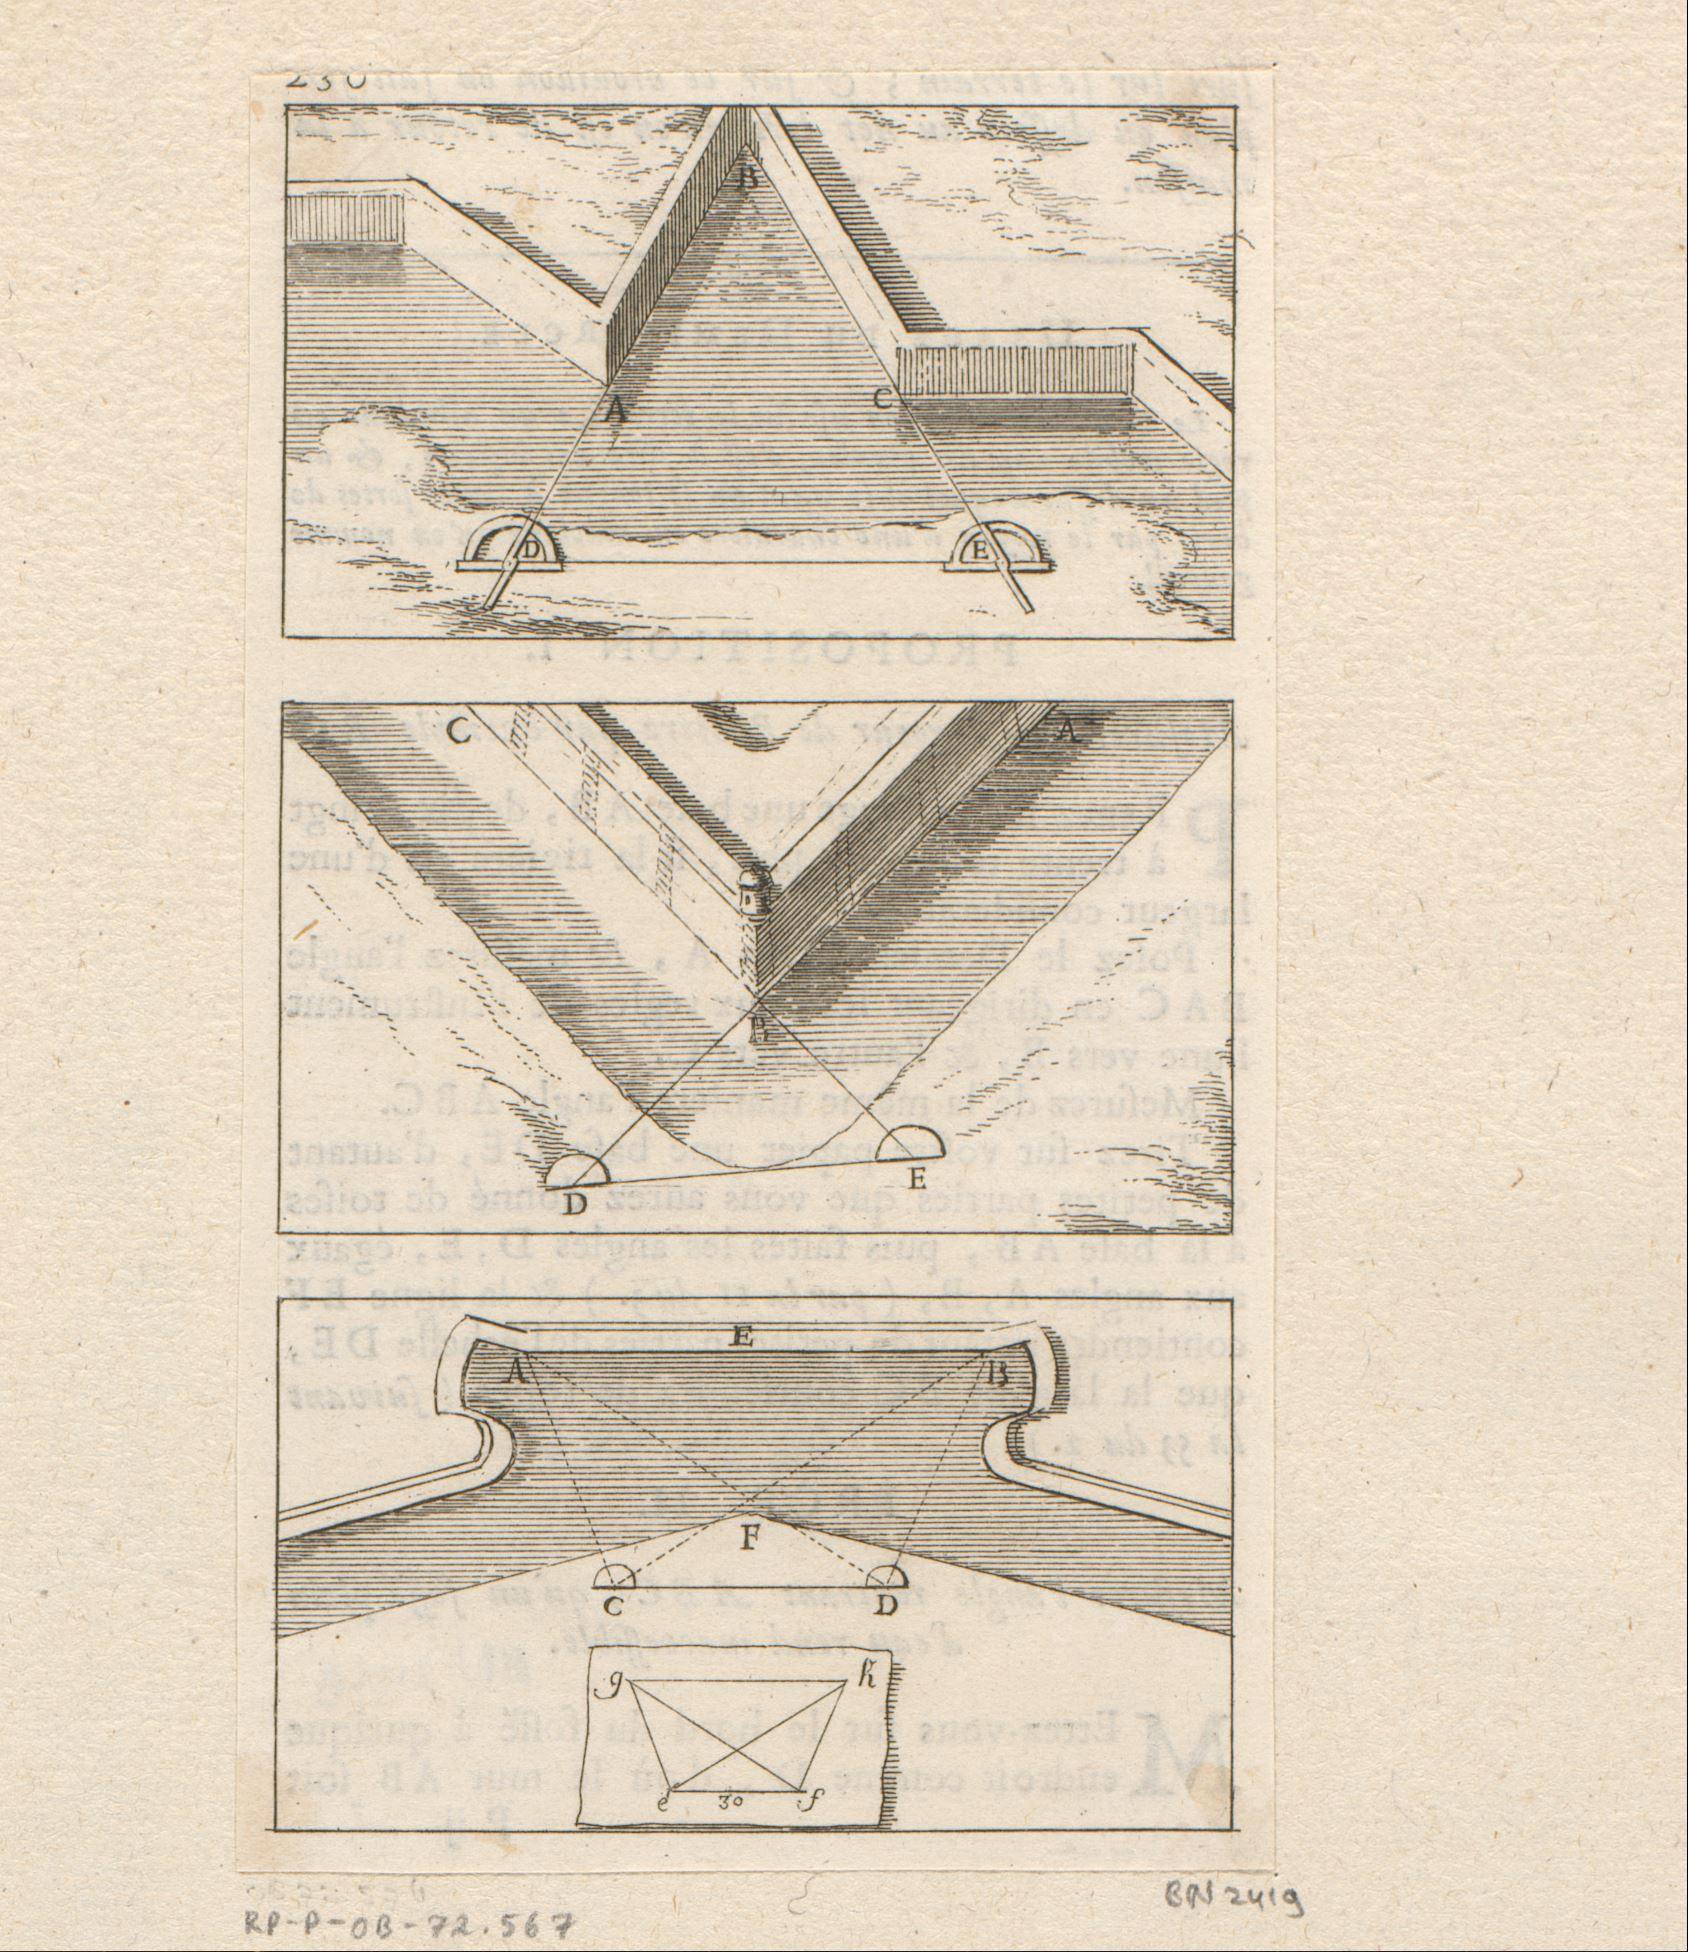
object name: print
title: Gebruik van de halve cirkel geïllustreerd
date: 1690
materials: paper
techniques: etching, letterpress printing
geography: france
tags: planimetry, geometry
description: Prent uit: Leclerc, Sébastien. Traité de géométrie (...). Parijs: Jean Jombert, 1690.